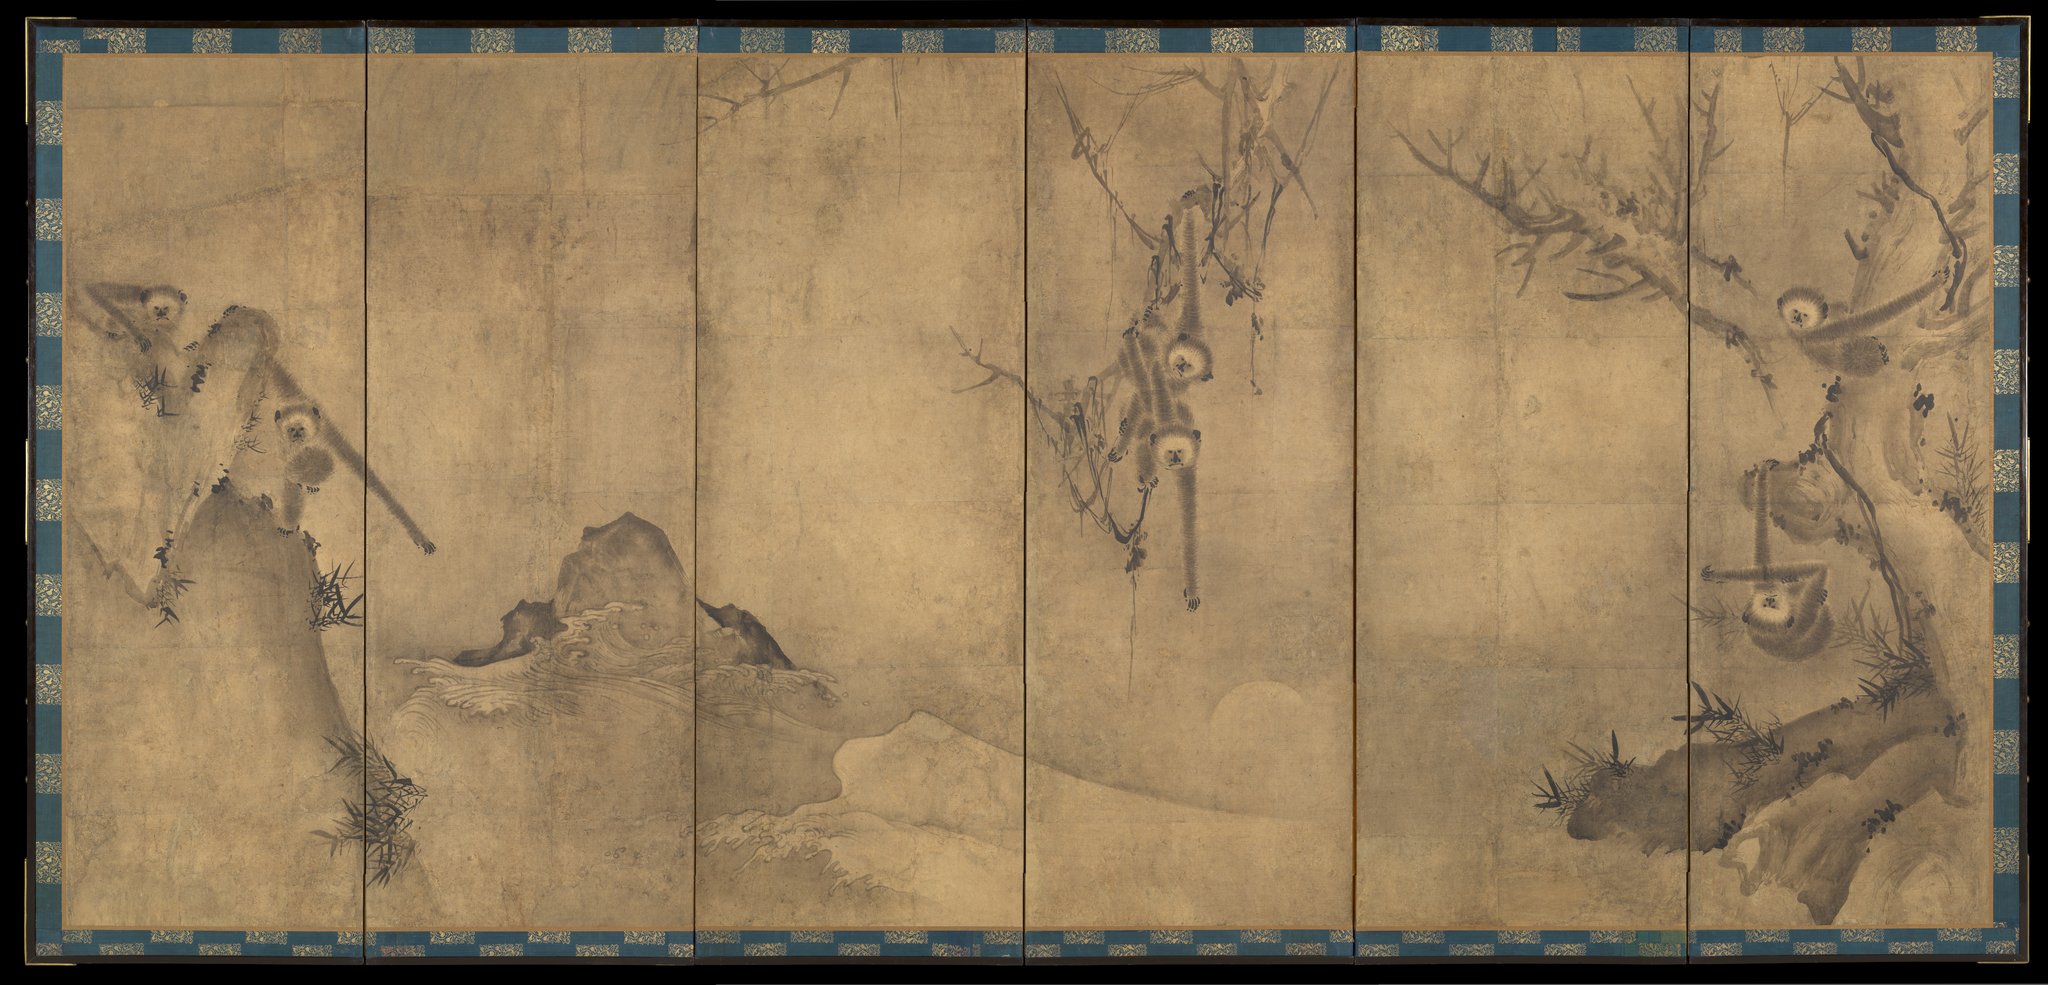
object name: screen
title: Gibbons in a Landscape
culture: japanese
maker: sesson shūkei 雪村周継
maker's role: artist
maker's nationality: japanese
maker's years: 1504-1589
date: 1570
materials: ink, panel, paper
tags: animals,landscapes